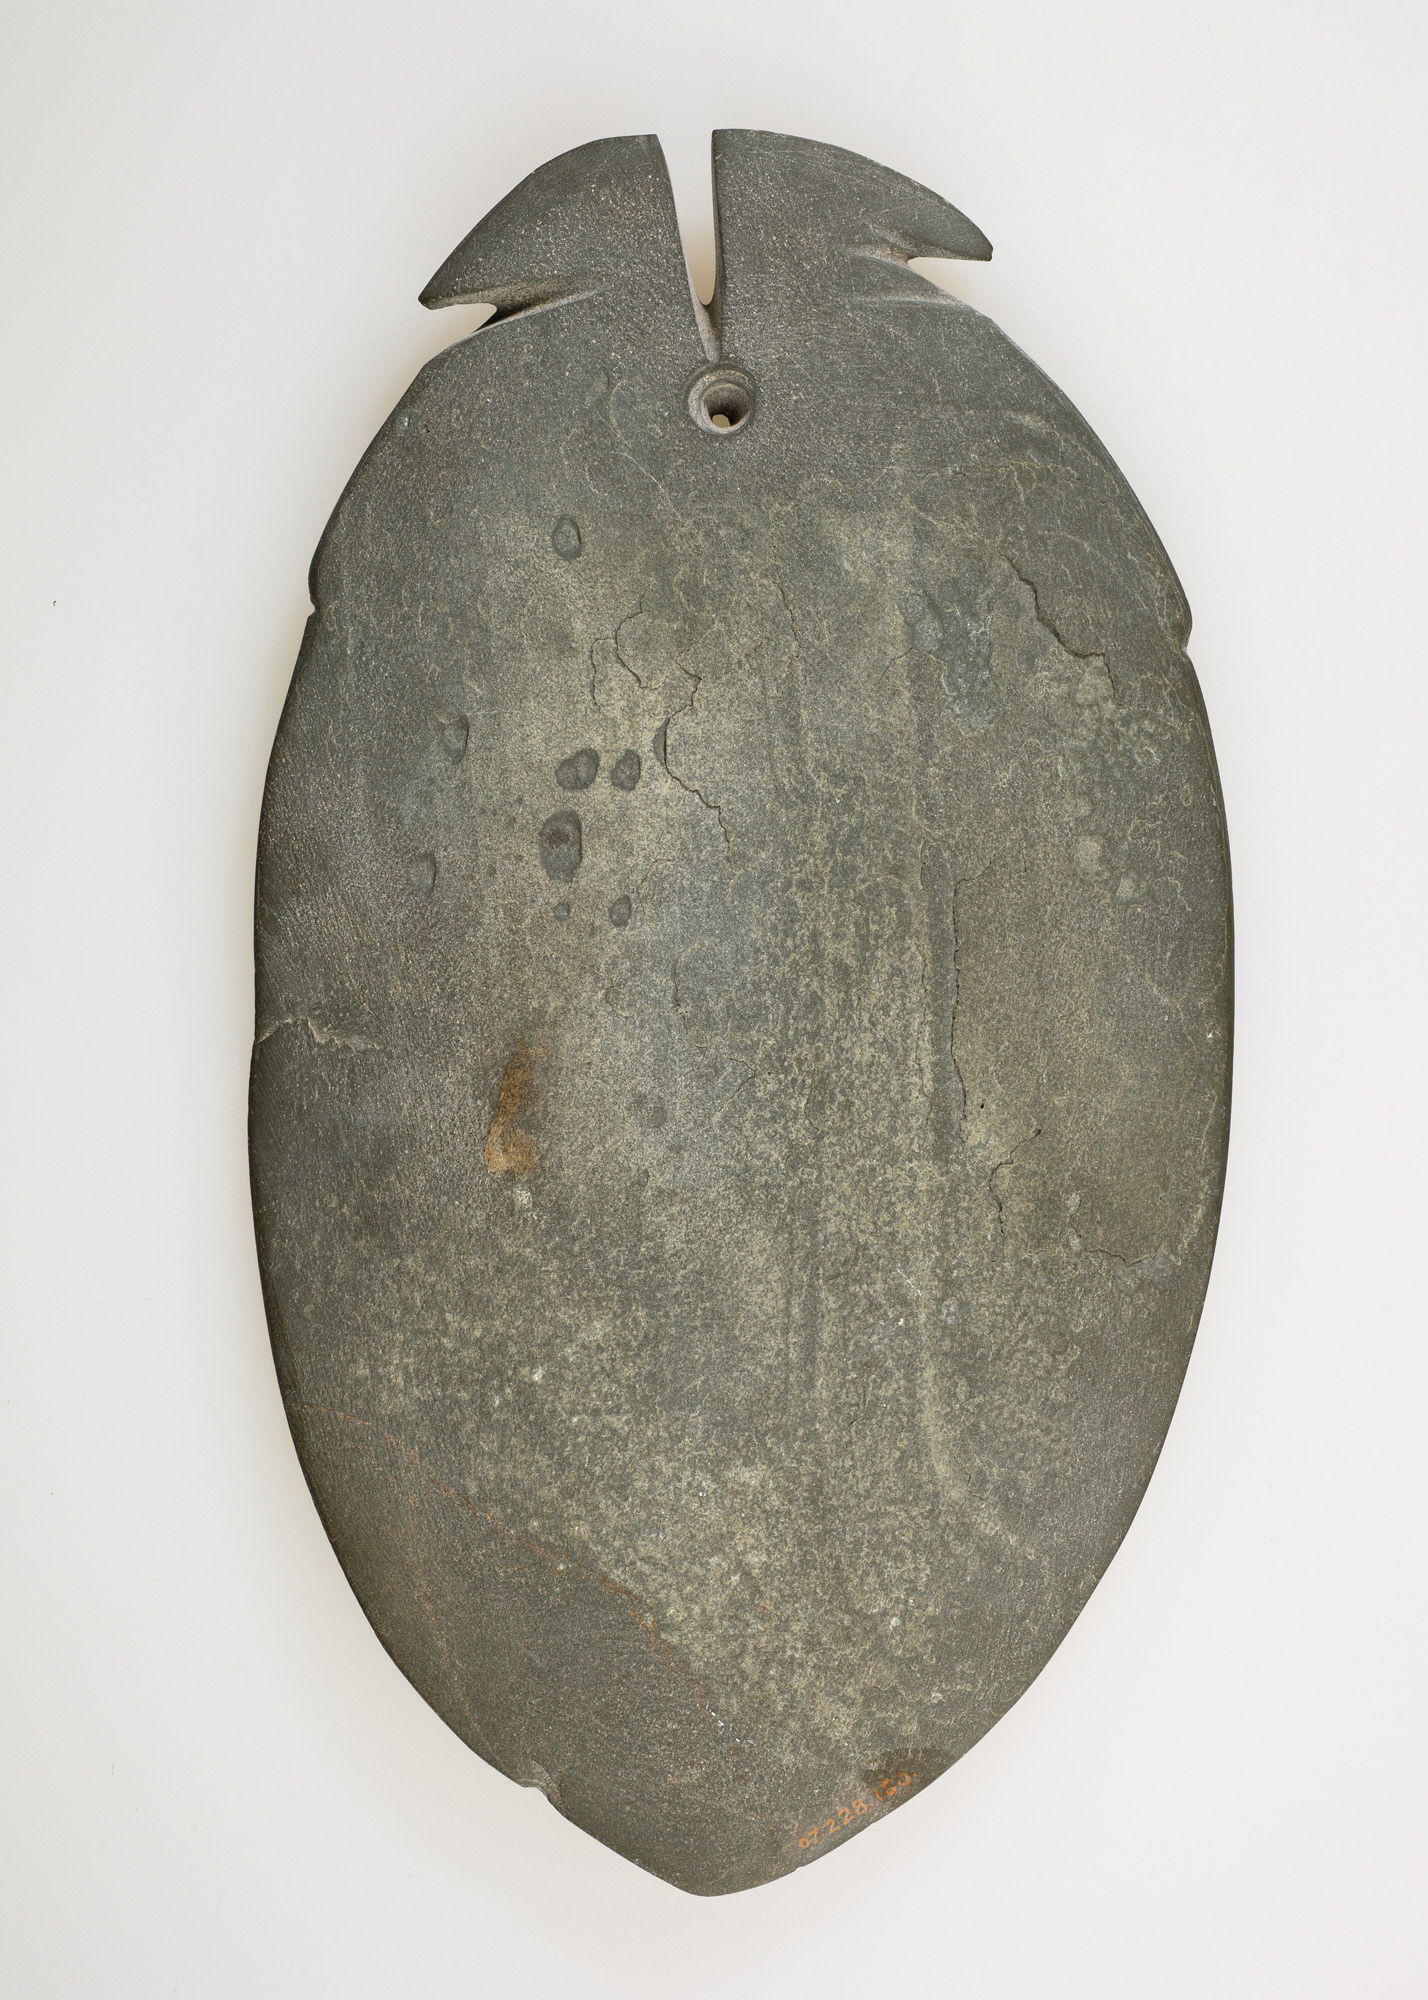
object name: palette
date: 4500-4000 BCE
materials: stone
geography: egypt